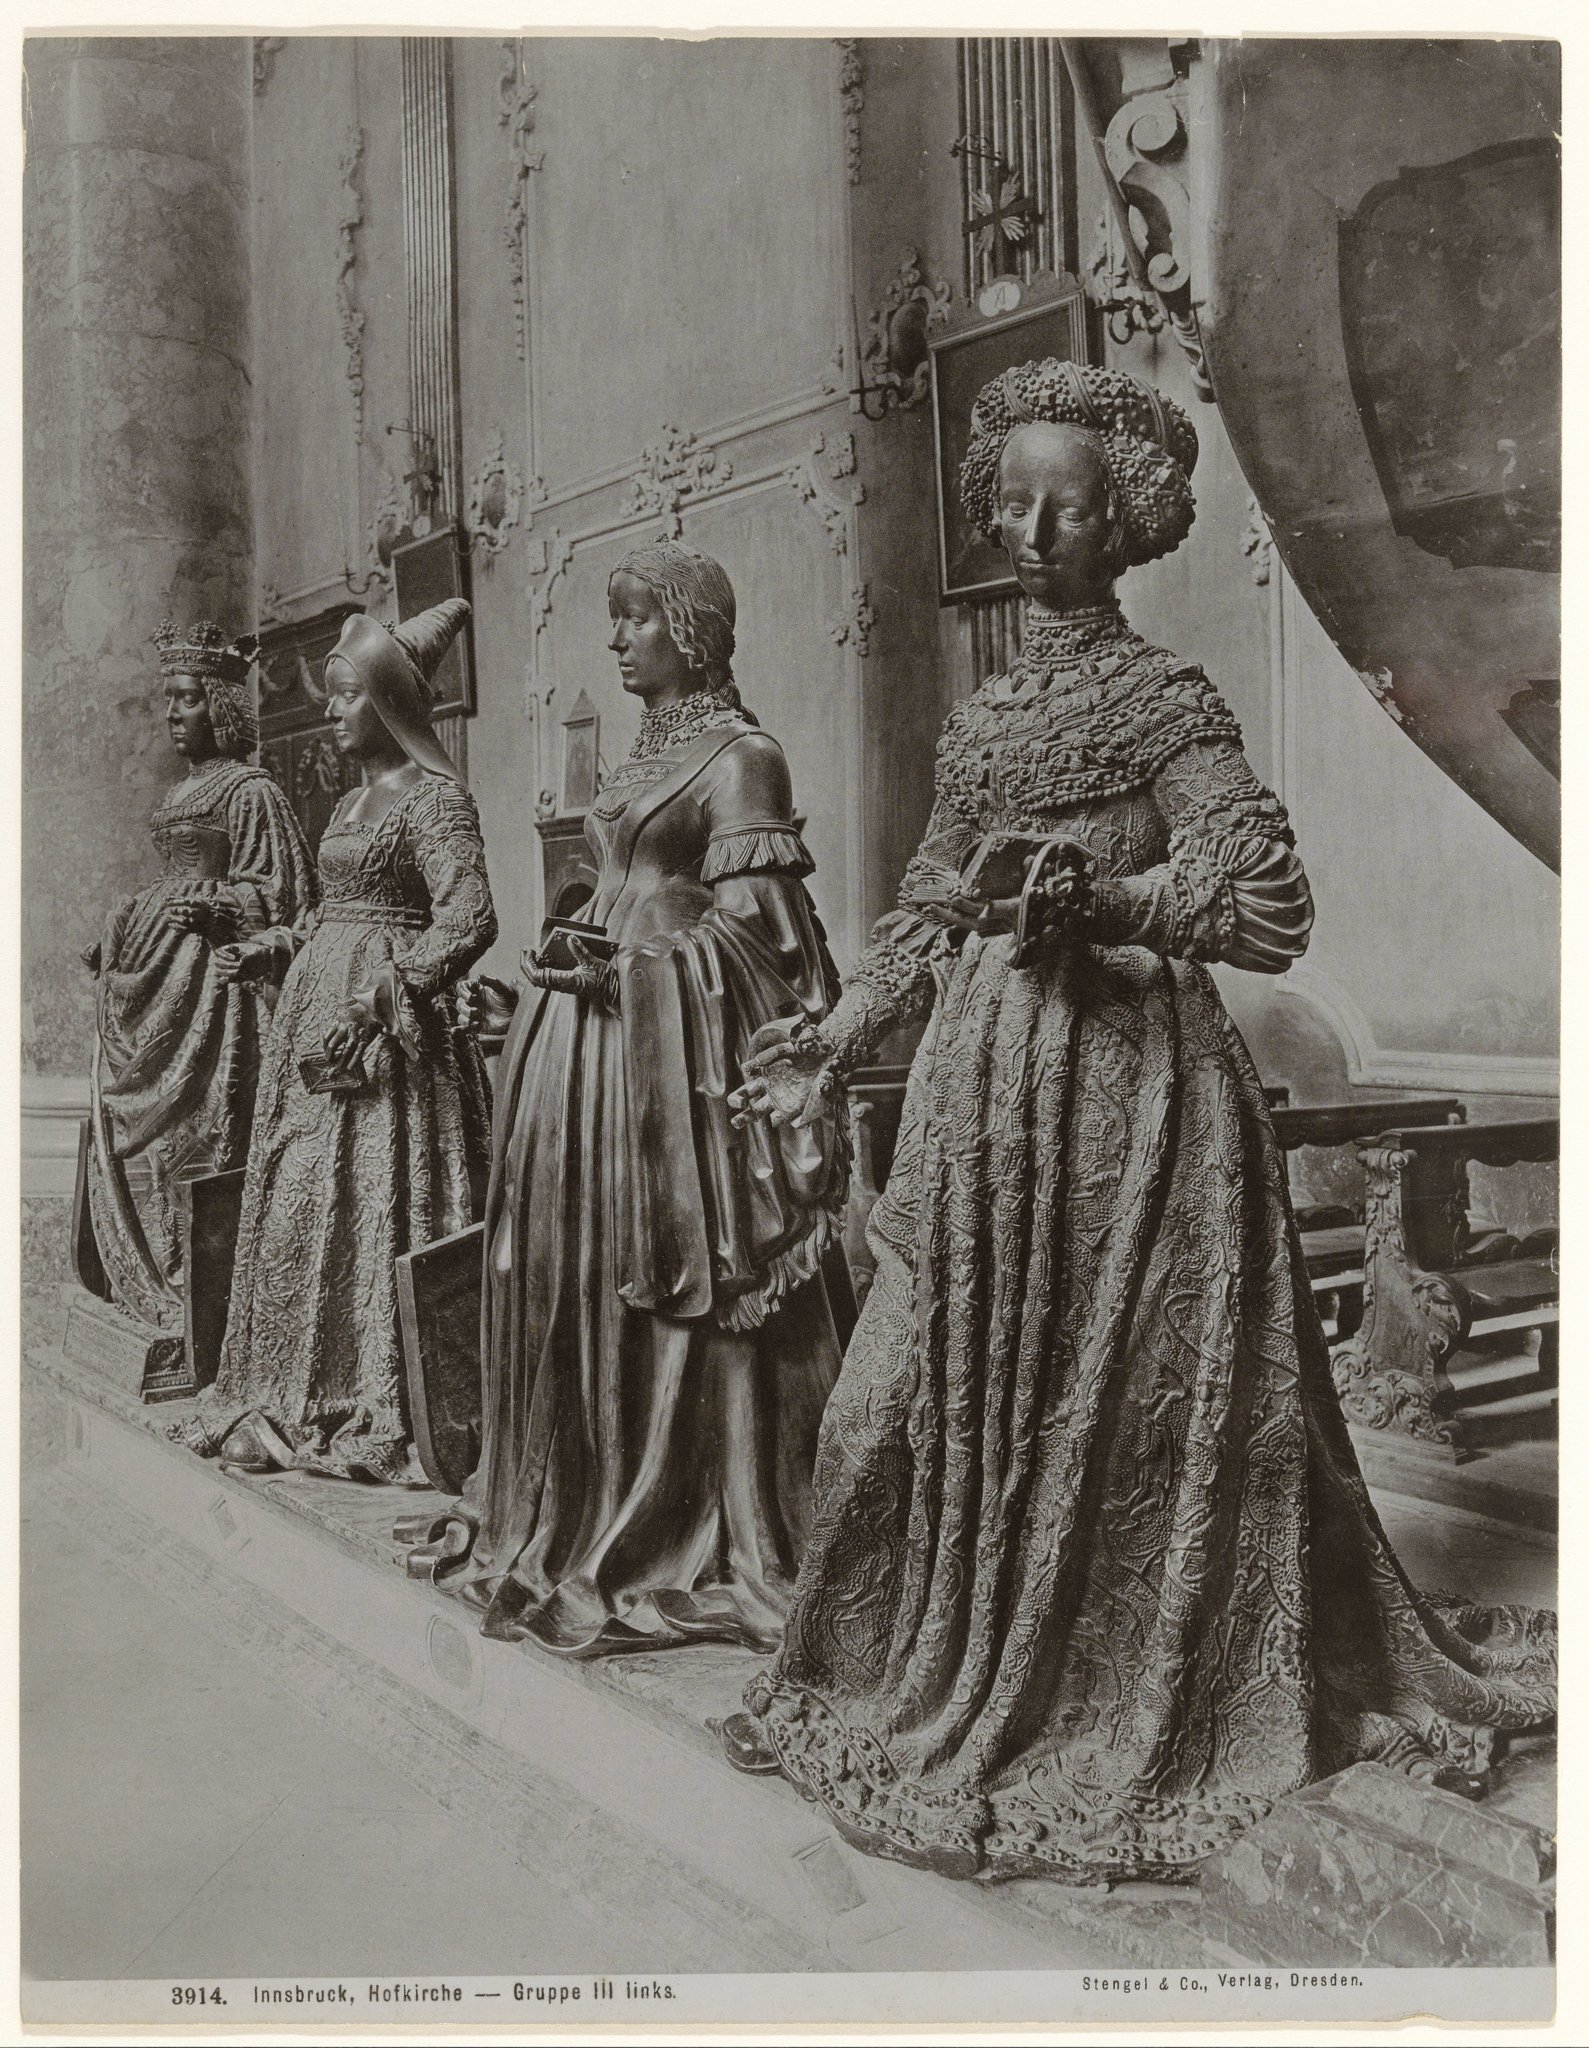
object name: photomechanical print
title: Innsbruck, Hofkirche - Gruppe III links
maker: Anonymous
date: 1889-1910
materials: paper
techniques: photograph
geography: innsbruck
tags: piece of sculpture, reproduction of a piece of sculpture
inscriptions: inscription: ‘45/ KGETT [?]’, title: ‘3914. Innsbruck, Hofkirche - Gruppe III links. Stengel & Co., Verlag, Dresden.’